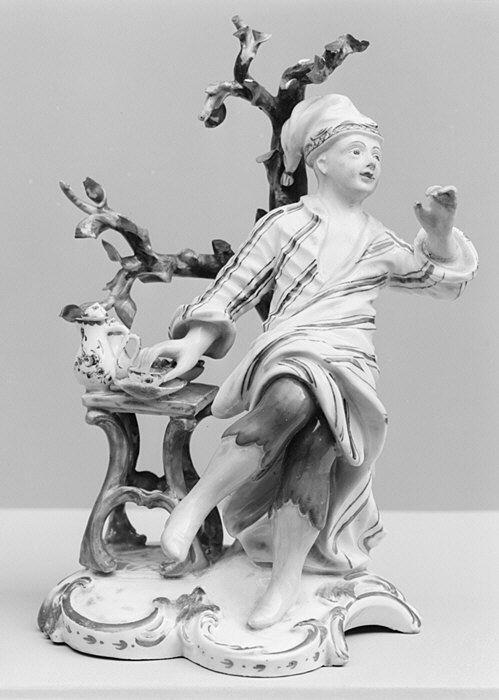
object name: figure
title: The Morning Coffee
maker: höchst manufactory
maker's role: manufactory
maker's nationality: german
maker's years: 1746-1796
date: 1755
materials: hard paste porcelain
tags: men